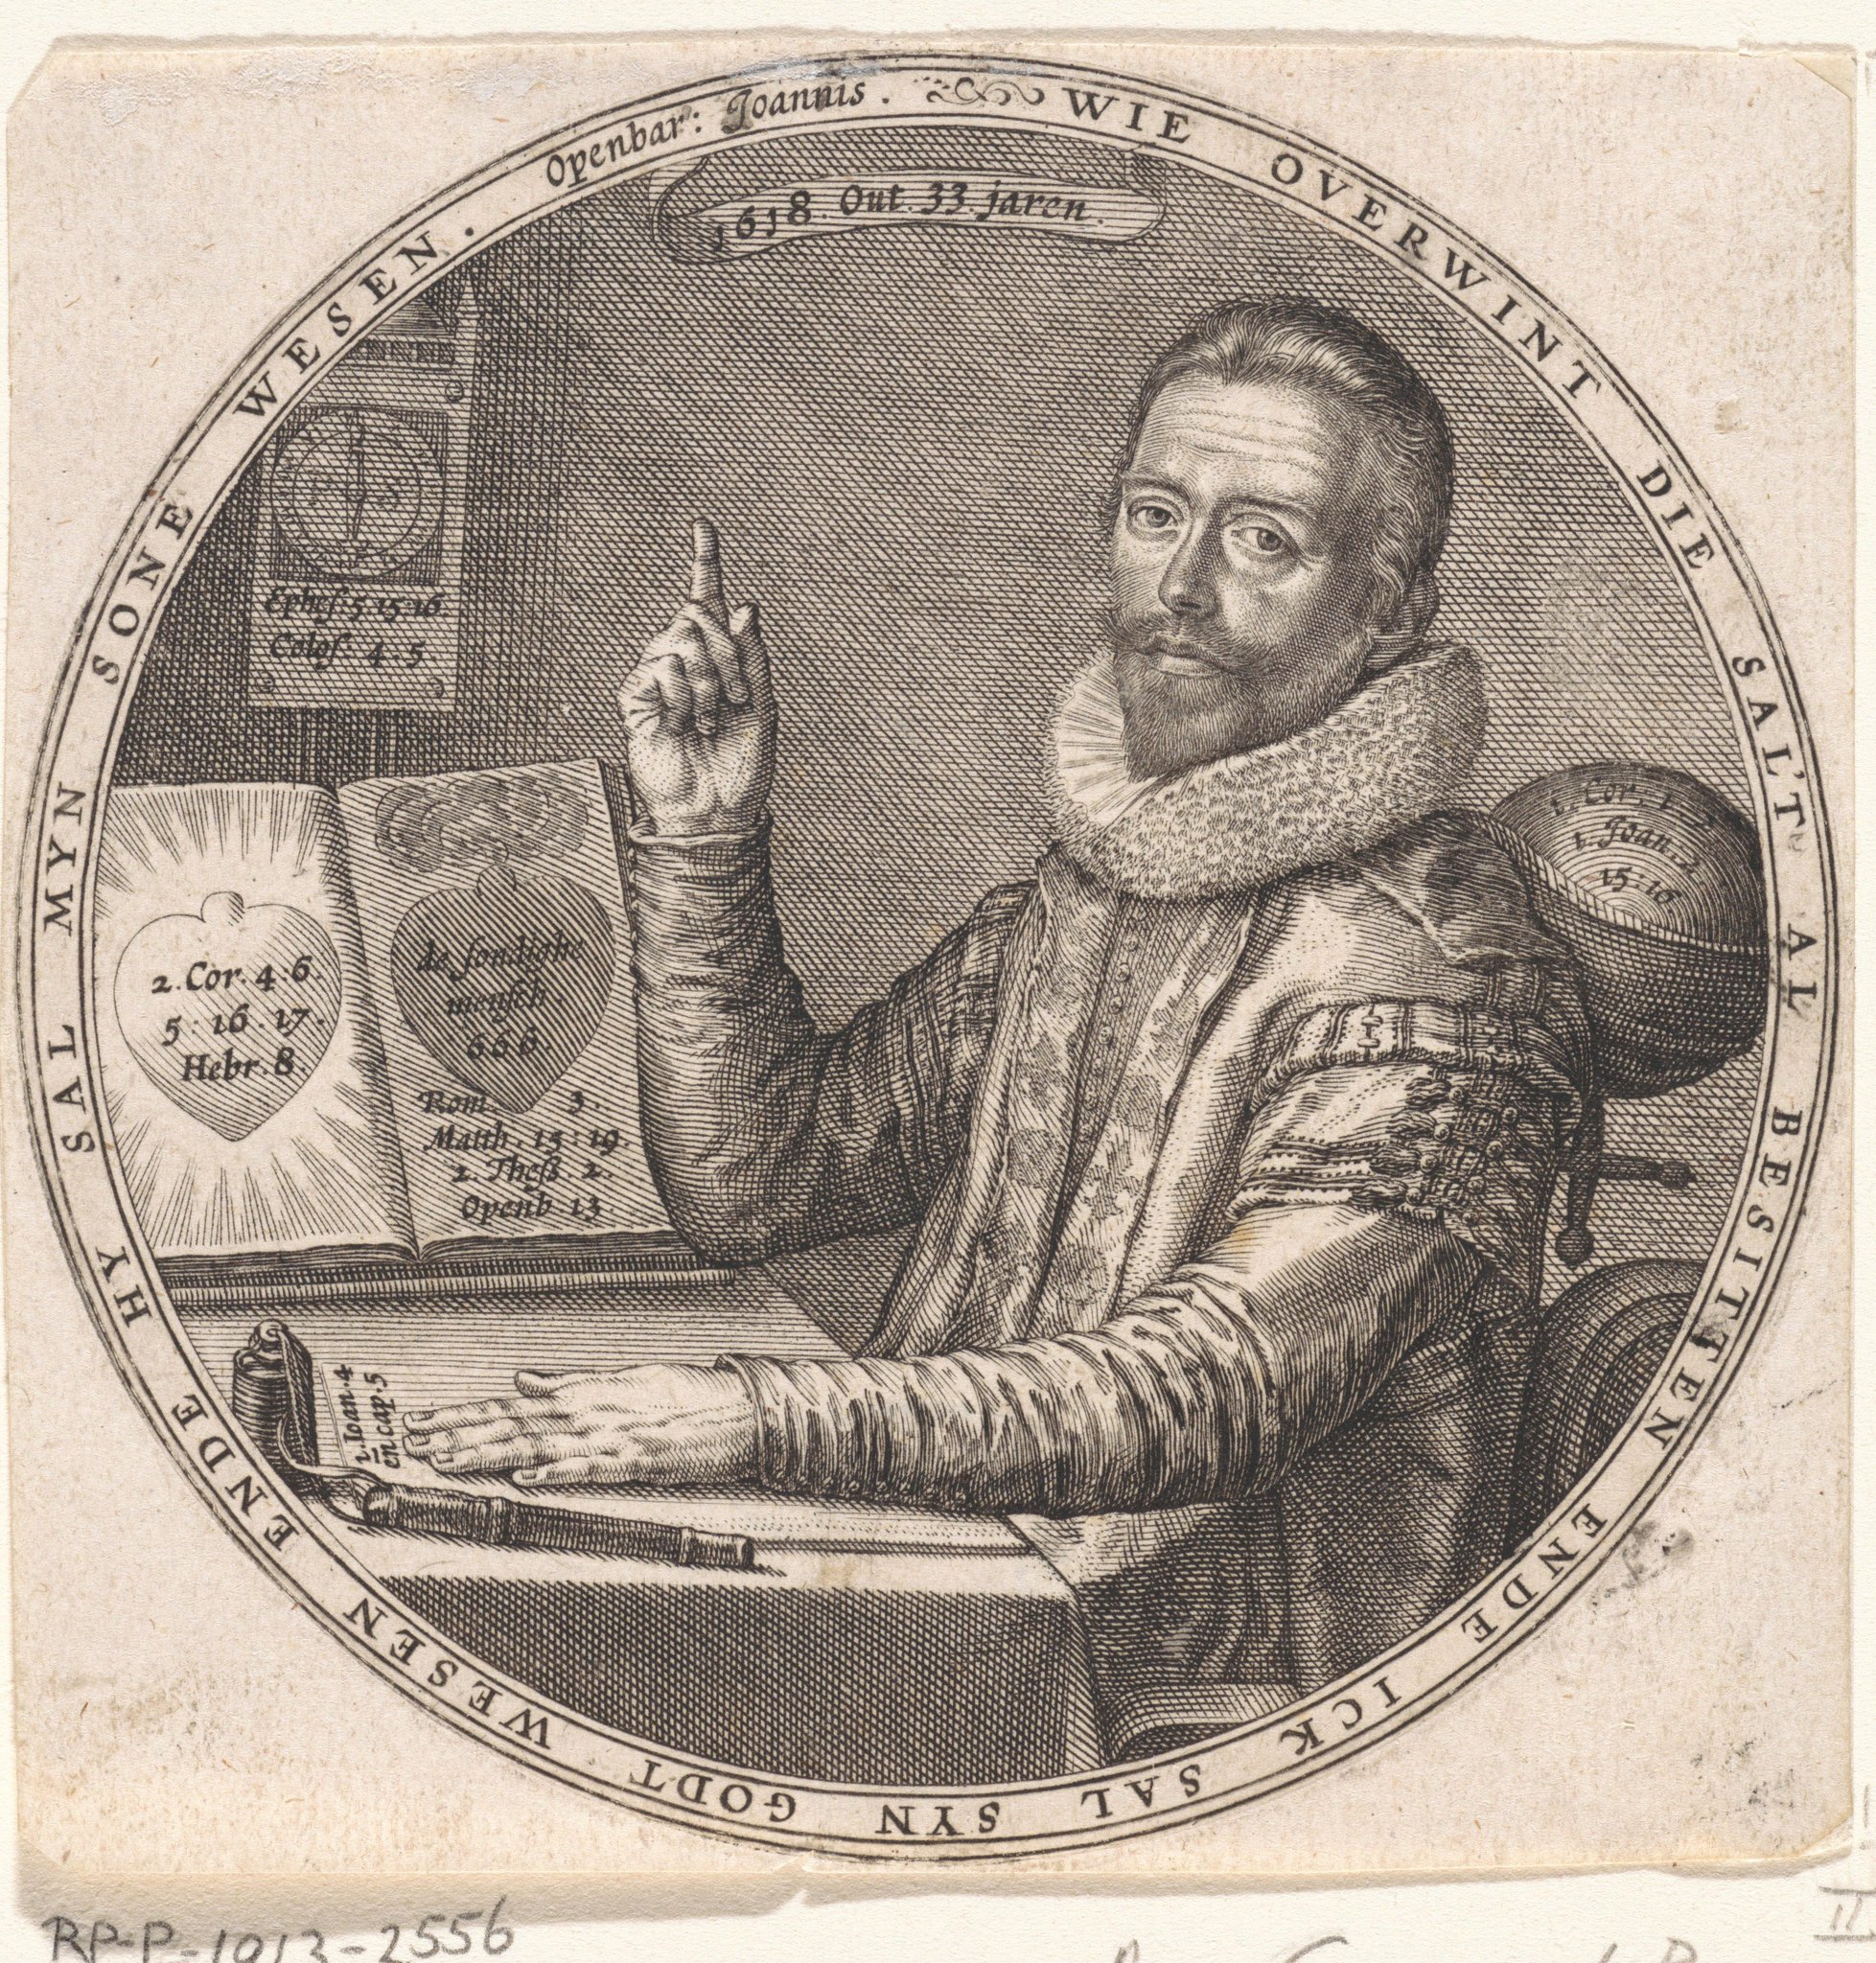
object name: print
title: Portret van Nicolaas Grevinkhoven of van Vincent Anthonissoon van Drielenburgh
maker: pieter serwouters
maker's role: draughtsman, print maker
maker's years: 1586-1657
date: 1618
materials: paper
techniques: engraving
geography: amsterdam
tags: book - mm - book open, clock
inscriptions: collector's mark: Lugt 2228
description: Portret van de Remonstrantse predikant Nicolaas Grevinkhoven of van de jurist en Contra-remonstrantse geestdrijver Vincent Anthonissoon van Drielenburgh op 33-jarige leeftijd. Hij zit aan een tafel met zijn hand op een met een verwijzing naar een Bijbelvers beschreven vel papier. Op tafel een open geslagen boek, met een verwijzing naar verschillende Bijbelteksten, aan de muur een klok, eveneens met Bijbelverwijzingen. In de ronde randomlijsting een Bijbeltekst. Ander portret dan dat op de eerste staat.